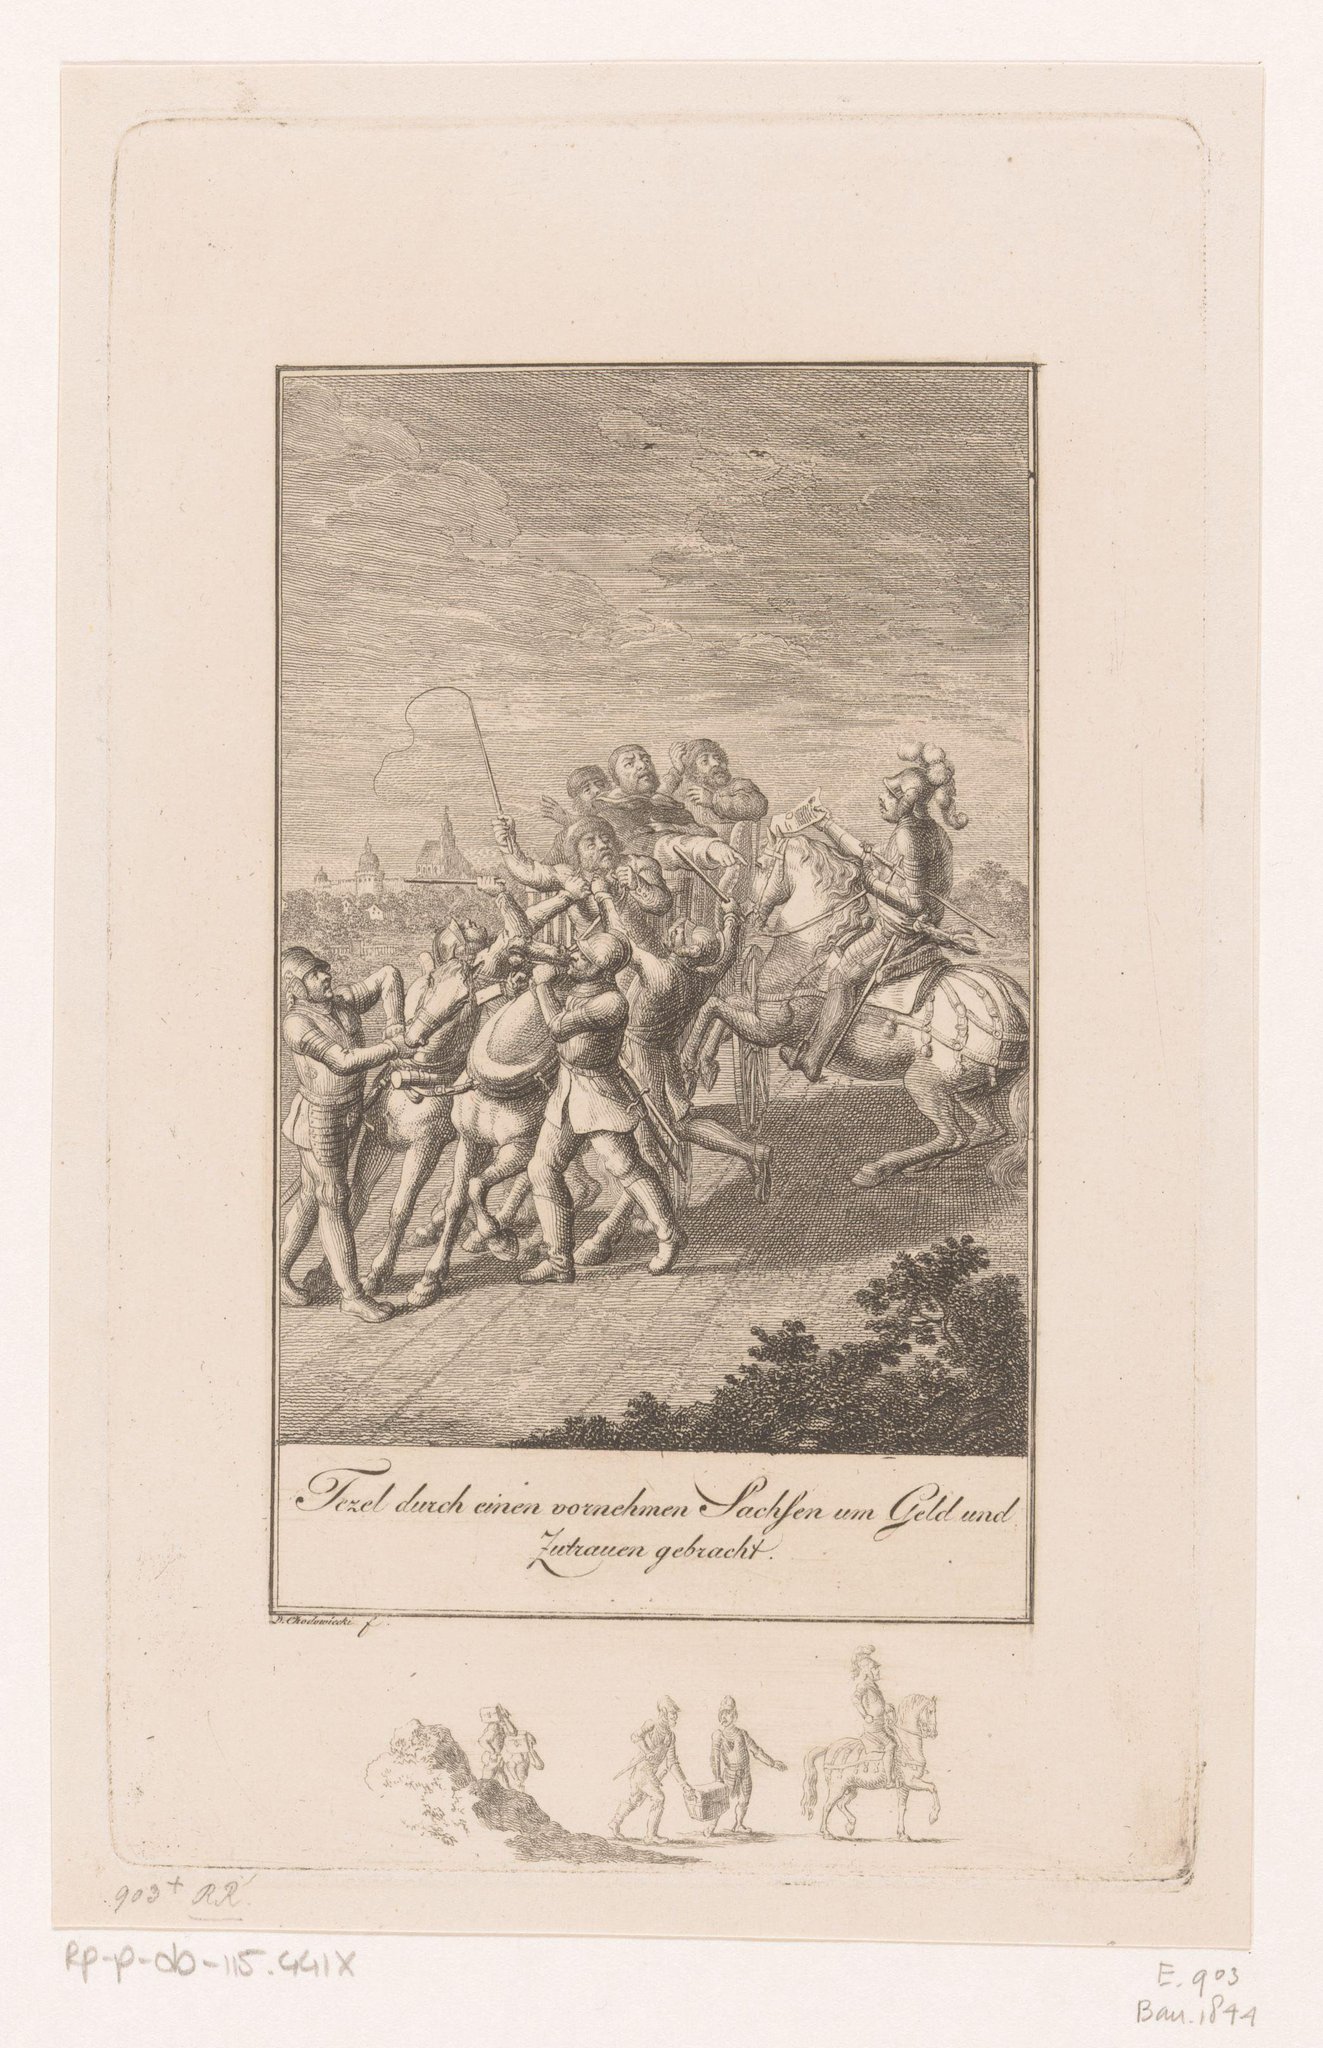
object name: print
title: Johannes Tetzel wordt nabij Leipzig overvallen en beschuldigd aflatenhandel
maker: daniel nikolaus chodowiecki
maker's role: draughtsman, print maker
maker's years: 1726-1801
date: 1798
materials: paper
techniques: etching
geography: berlin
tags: history, monk(s), friar(s), arrest (of criminal), indulgence, clemency; 'clemenza', 'clemenza & moderatione', 'indulgenza' (ripa)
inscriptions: collector's mark: Lugt 2228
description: Prent gebruikt voor: Deutsche Monatsschrift (...). 3 dln. Leipzig: Sommersche Buchhandlung, 1798.